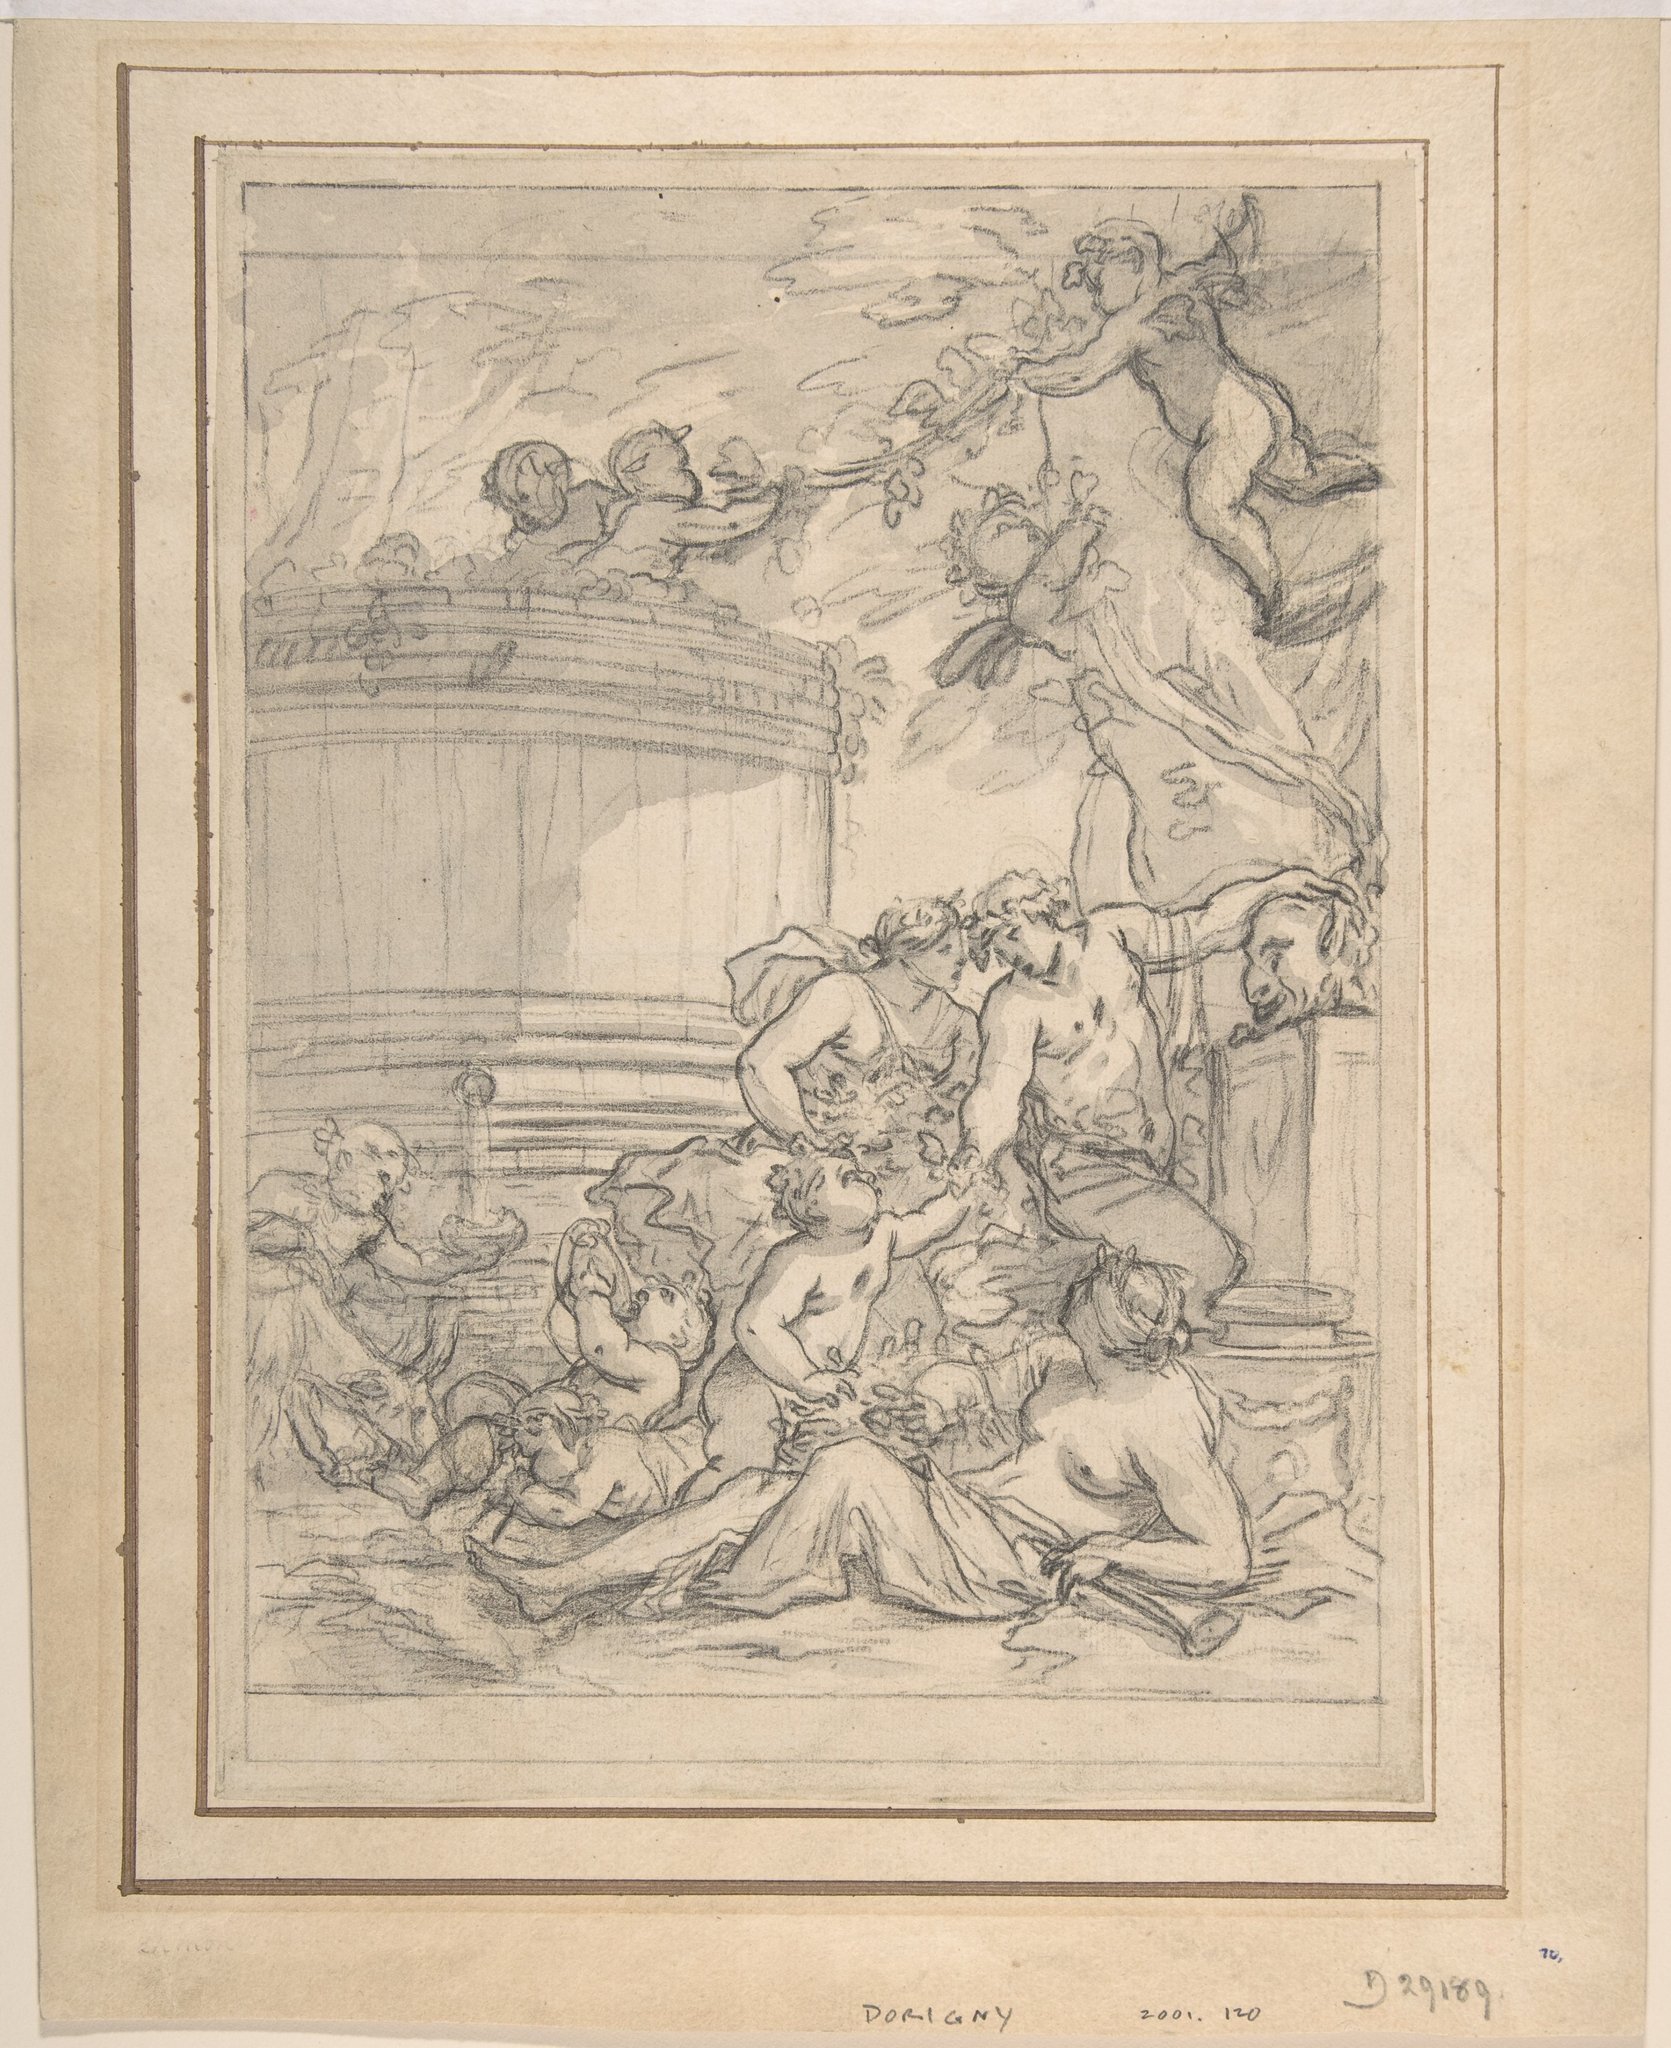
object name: drawing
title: Bacchanal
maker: michel dorigny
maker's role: artist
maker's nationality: french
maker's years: 1616-1665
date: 1601-1700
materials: chalk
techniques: brush, incising, wash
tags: heads,men,female nudes